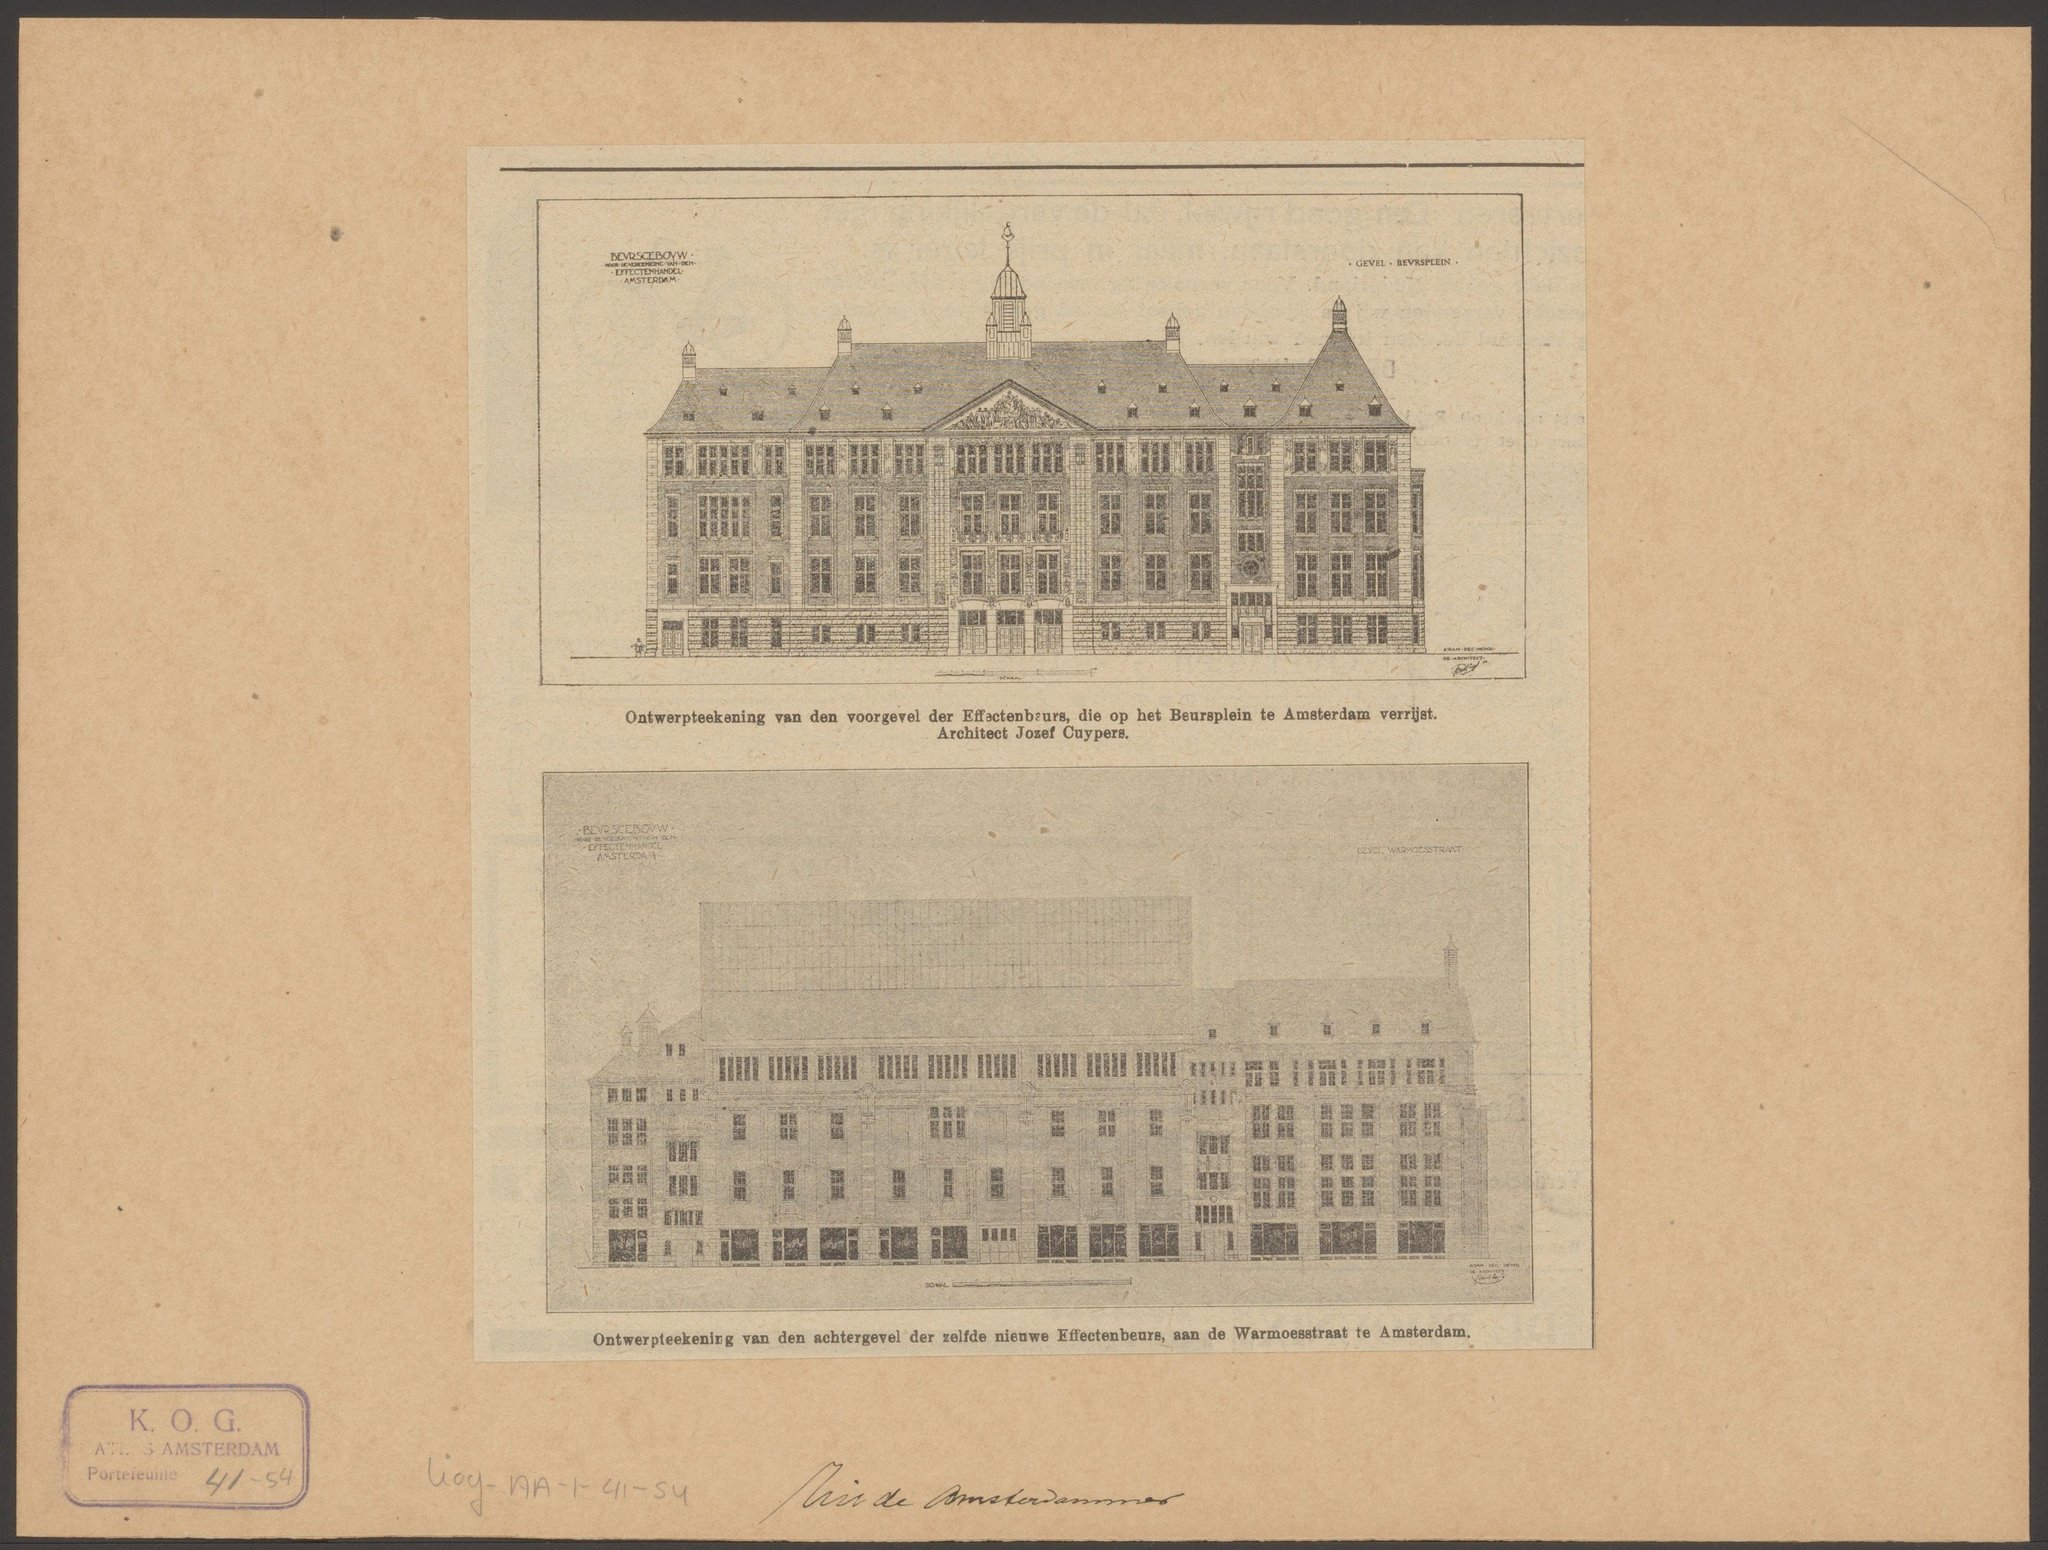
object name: photomechanical print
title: Ontwerp van de voor- en achtergevel van de Effectenbeurs te Amsterdam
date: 1911-1912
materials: paper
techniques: letterpress printing, line block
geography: amsterdam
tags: façade ~ architectural design or model, stock exchange, stock-market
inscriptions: collector's mark: ‘41-54’ Lugt 1641b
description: Onderwerpsrubriek binnen de Atlas Amsterdam: Nieuwe Effectenbeurs o/h Damrak (Beursplein).